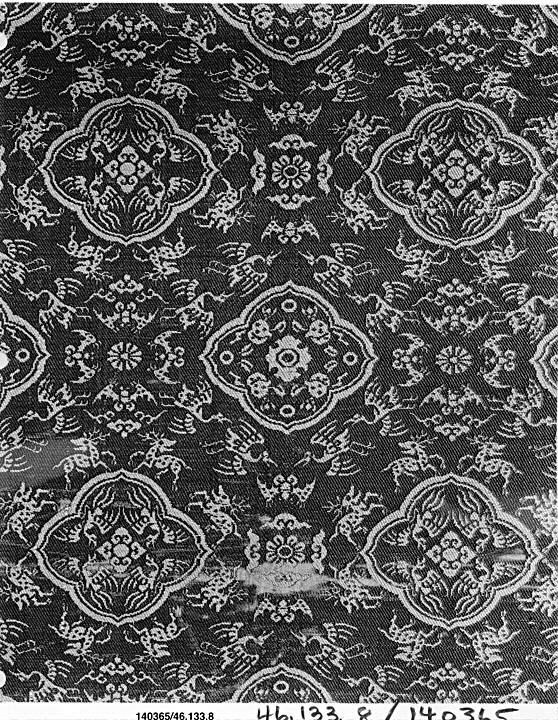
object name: piece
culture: chinese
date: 1201-1400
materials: silk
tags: bats,birds